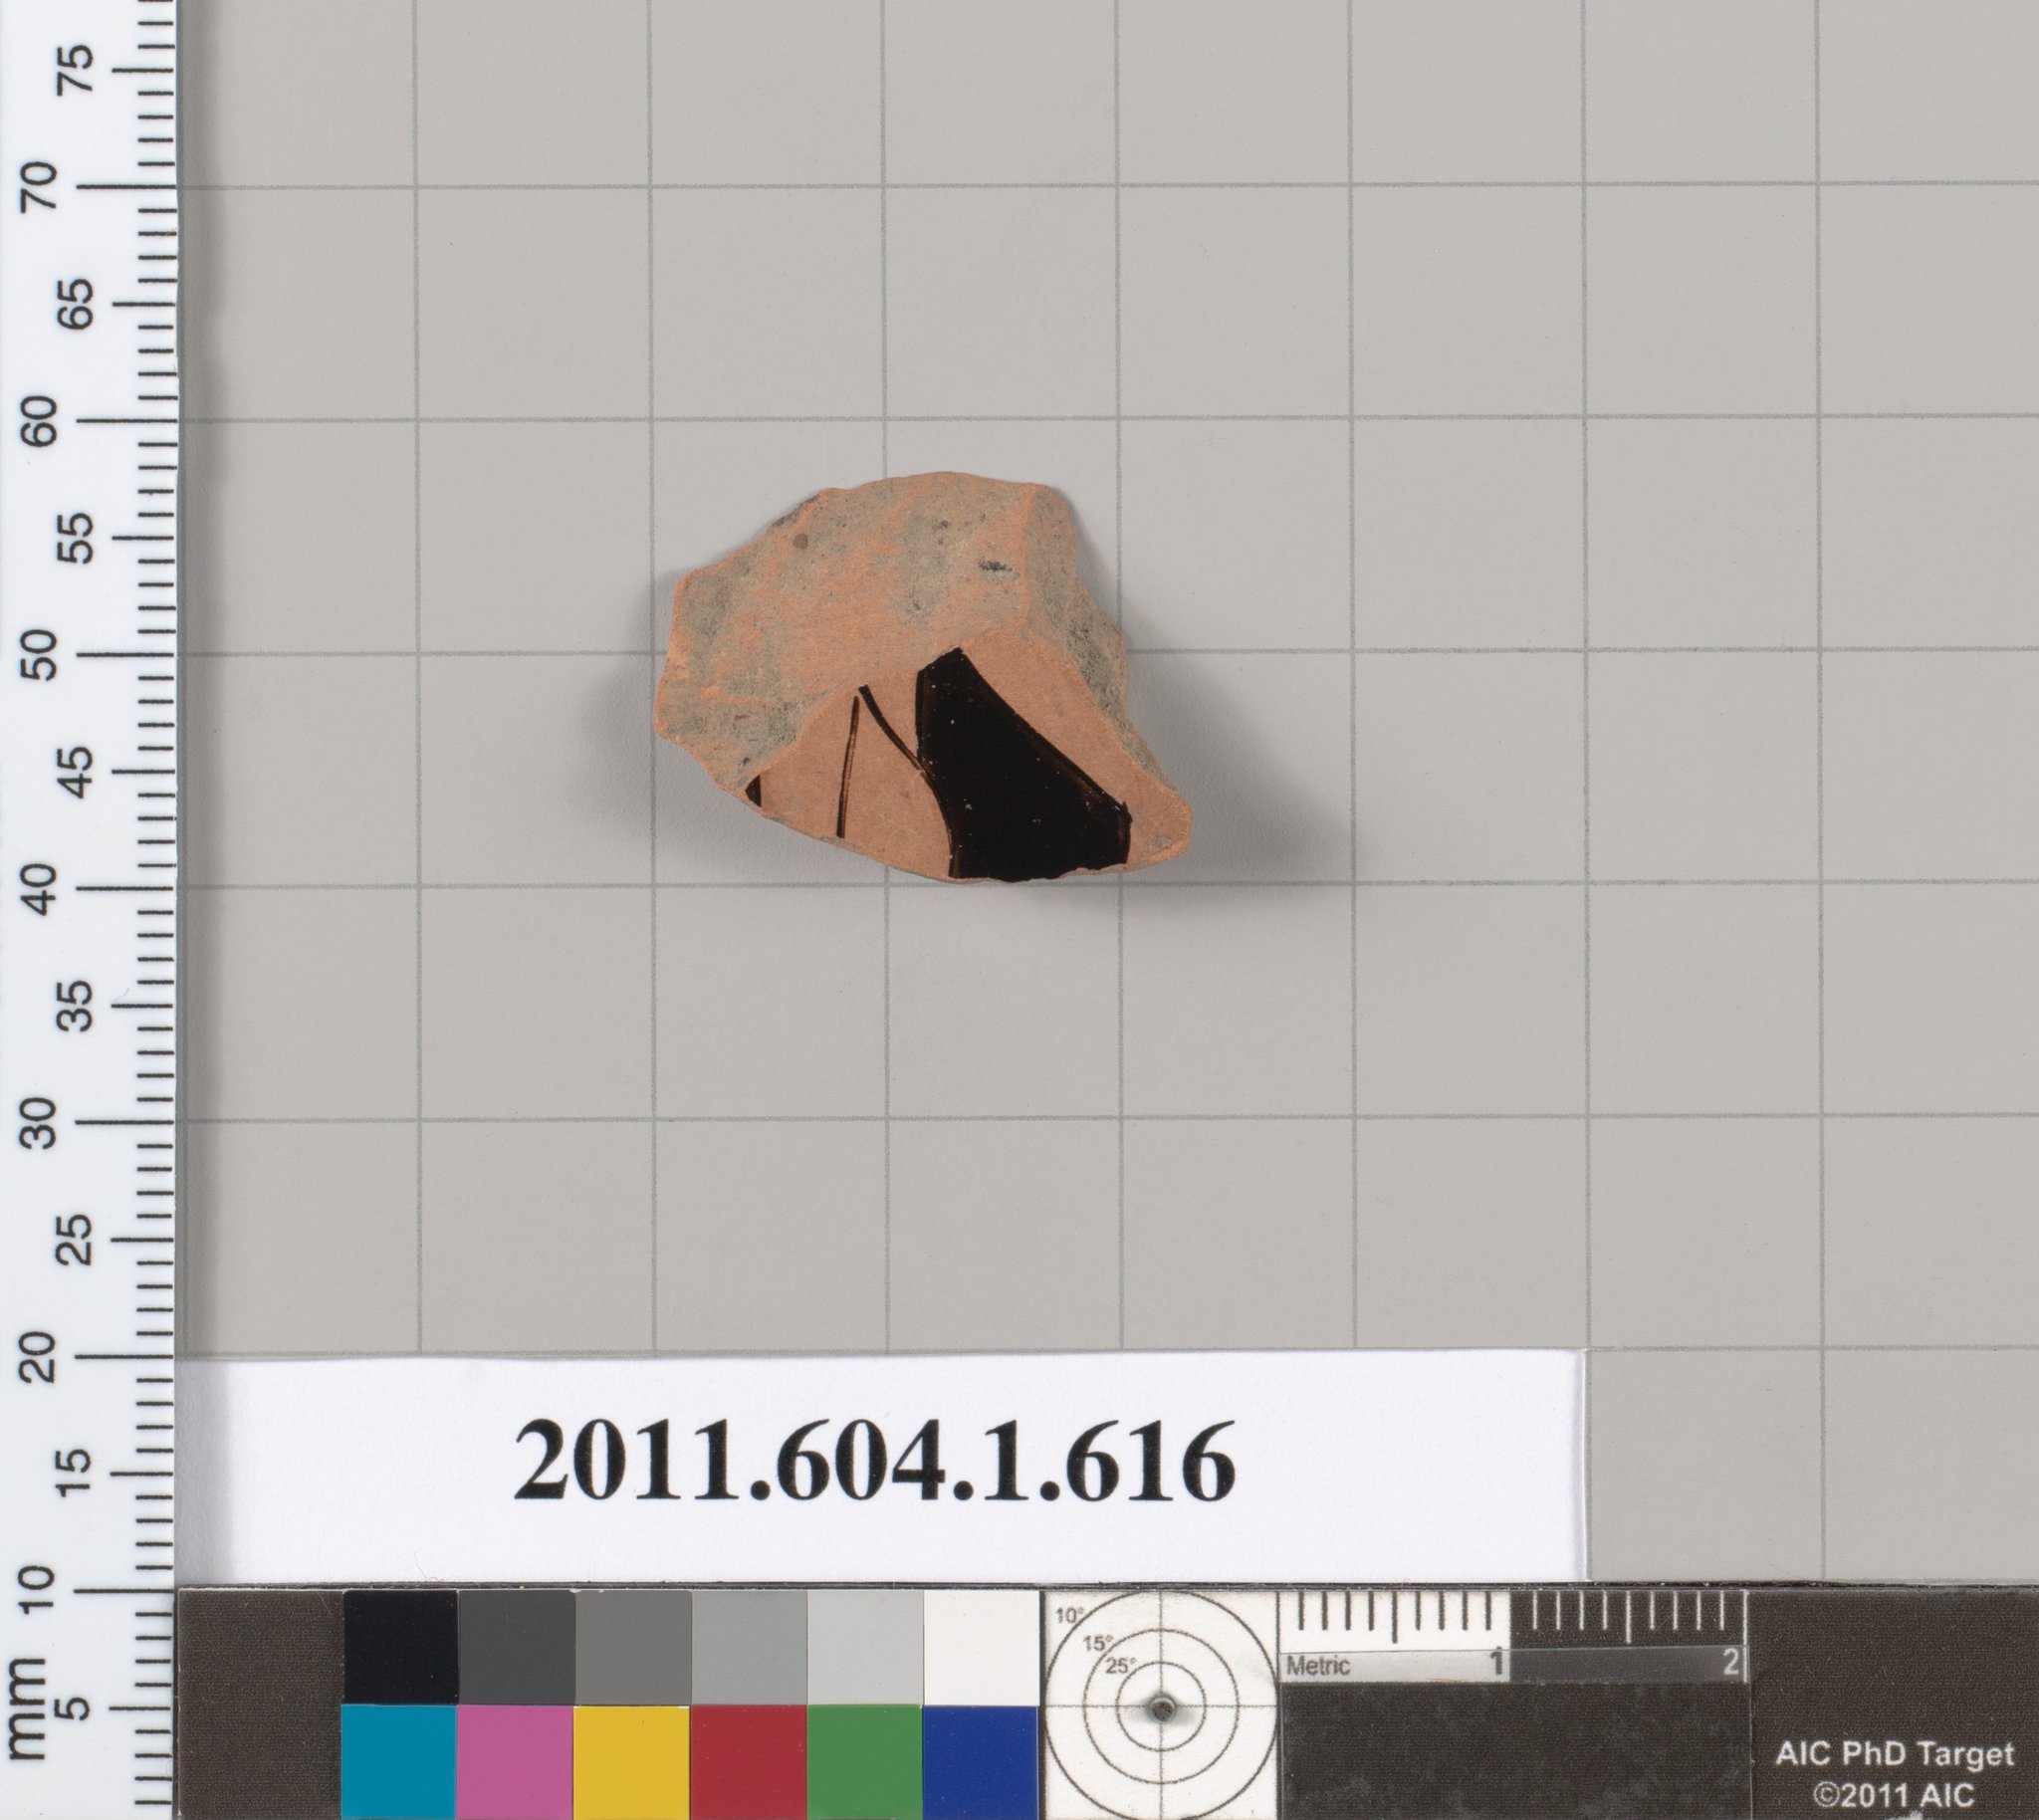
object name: kylix fragment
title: Terracotta fragment of a kylix (drinking cup)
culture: greek, attic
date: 475-451 BCE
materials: terracotta